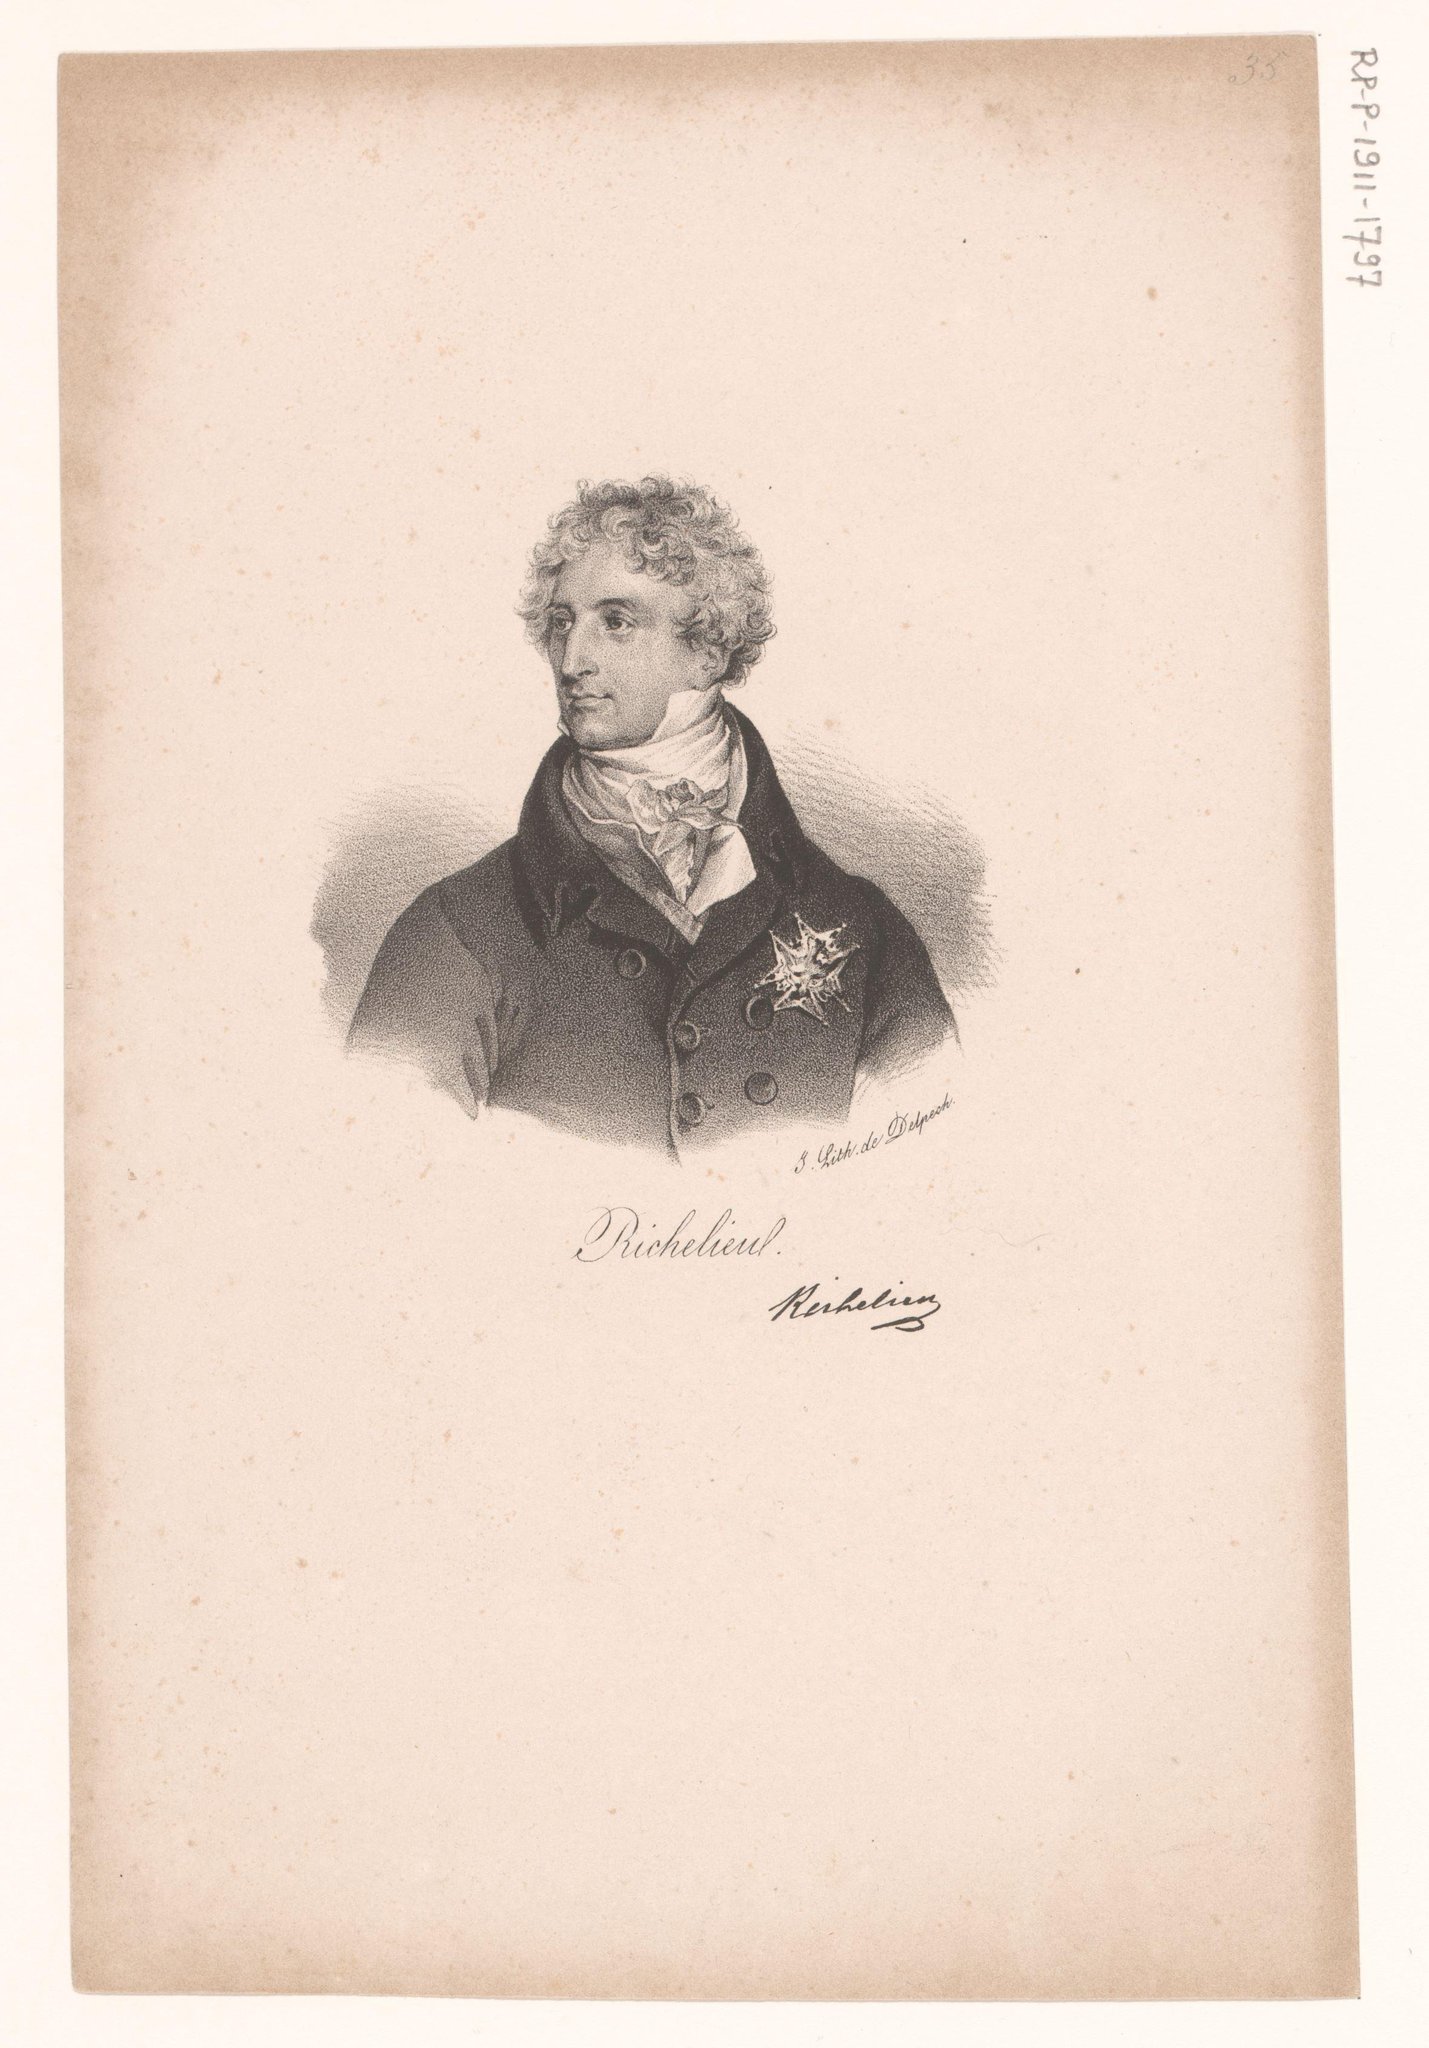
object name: print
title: Richelieu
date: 1818-1842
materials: paper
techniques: lithograph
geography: paris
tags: paris, historical persons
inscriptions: collector's mark: Lugt 2228a